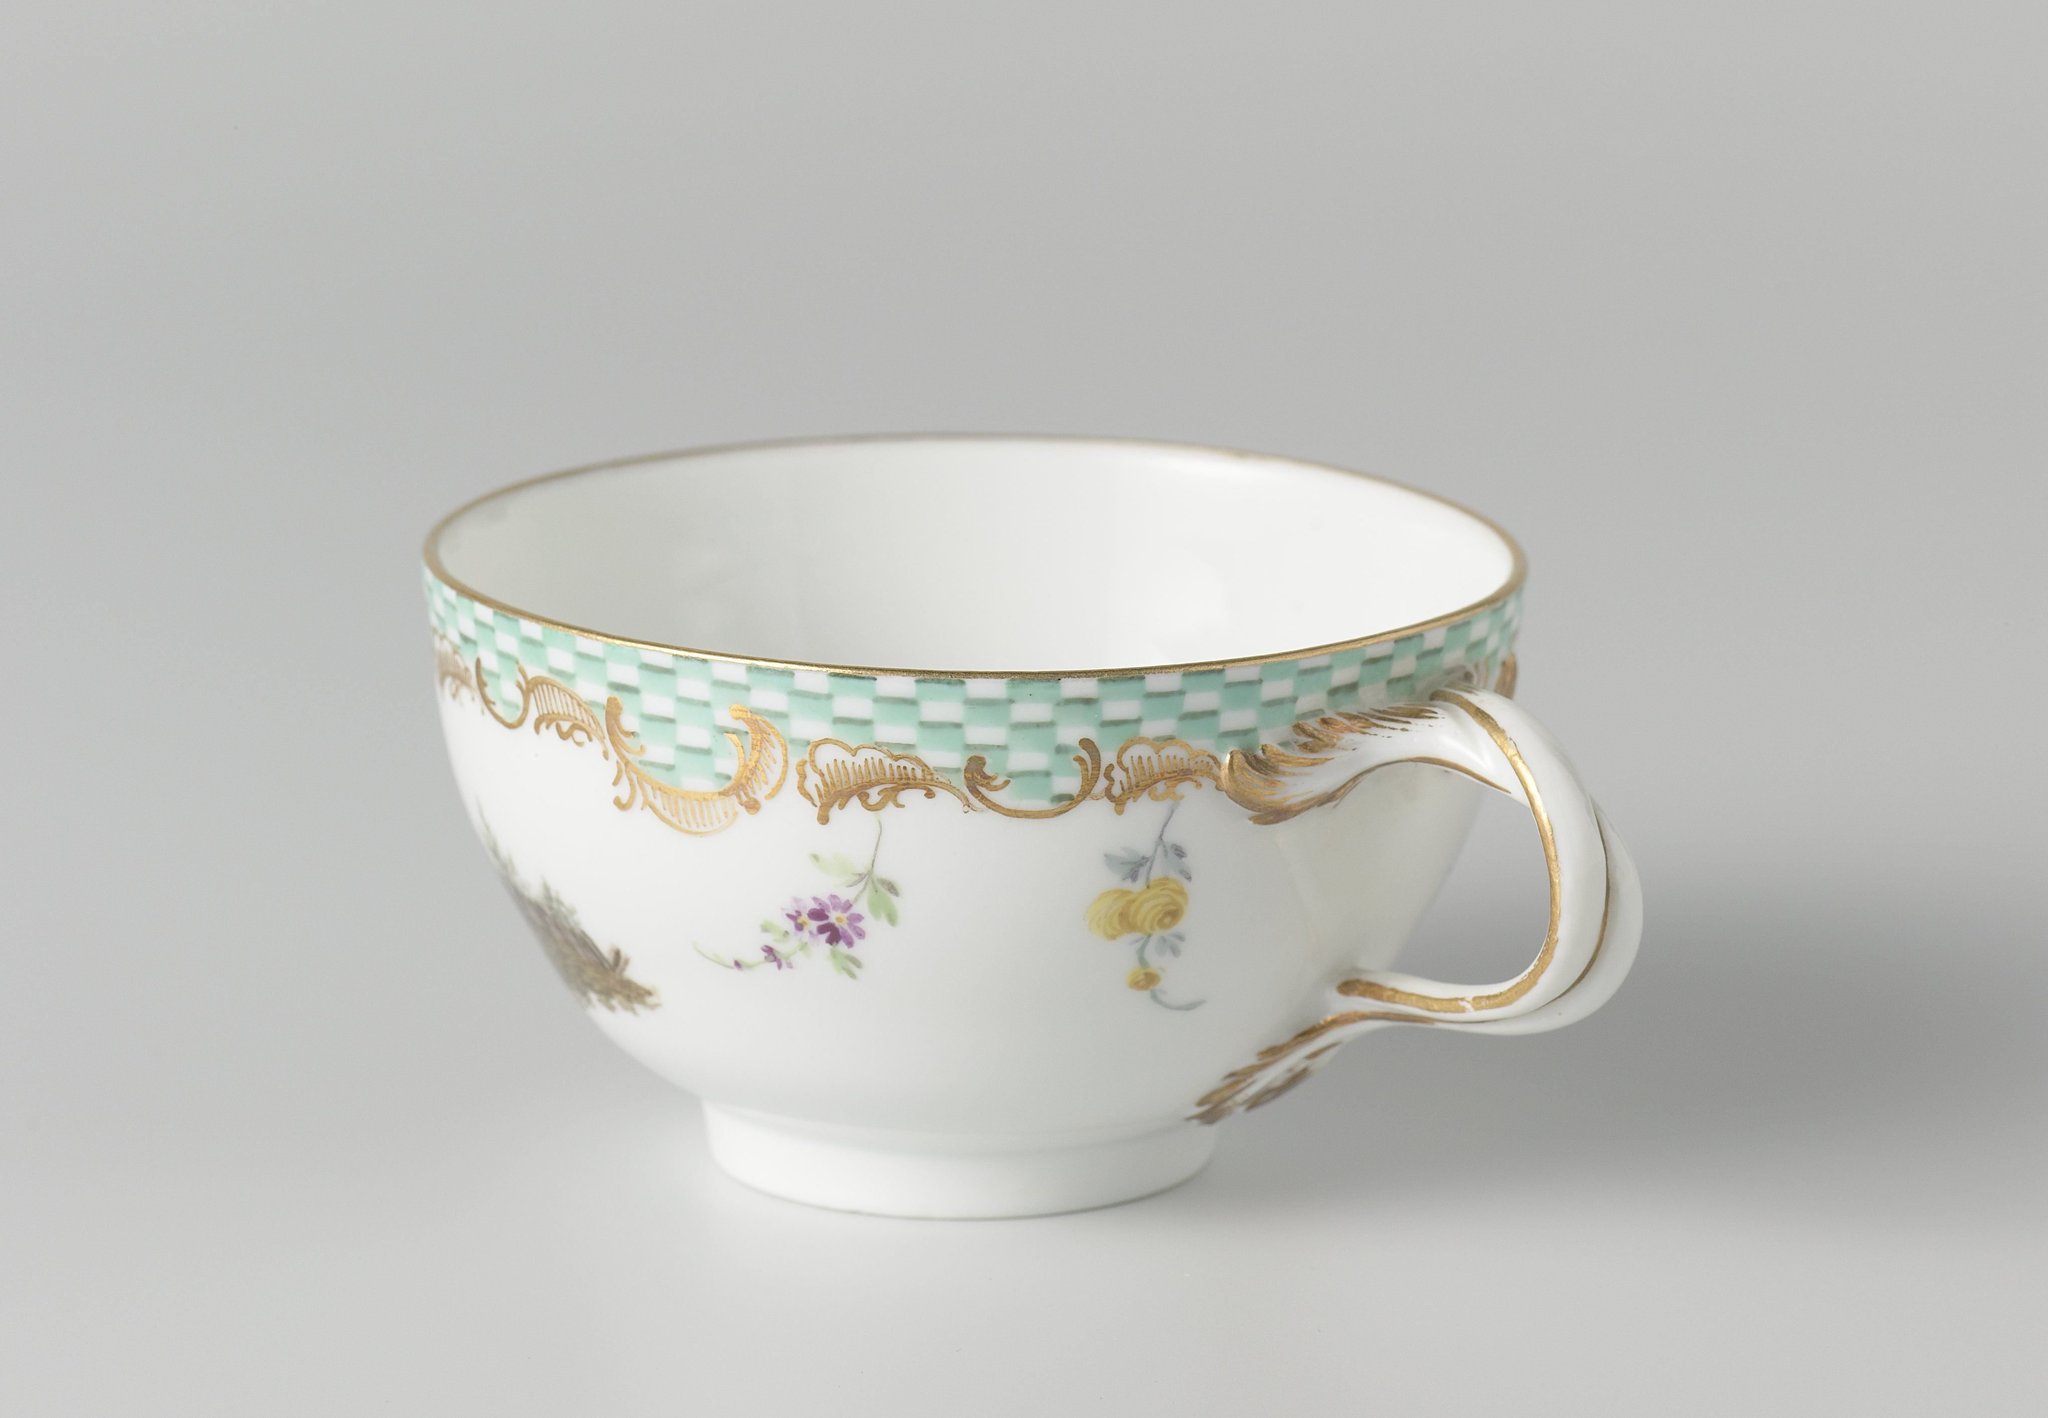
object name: eating drinking utensil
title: Kop, veelkleurig beschilderd met een landschap met figuren.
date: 1777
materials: porcelain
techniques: painted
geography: meissen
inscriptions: mold mark: ‘18’, factory mark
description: Lage kop met oor, van beschilderd porselein. De kop is beschilderd met landschappen waarin figuren en langs de rand een brede strook groen vlechtwerk. De kop is gemerkt.